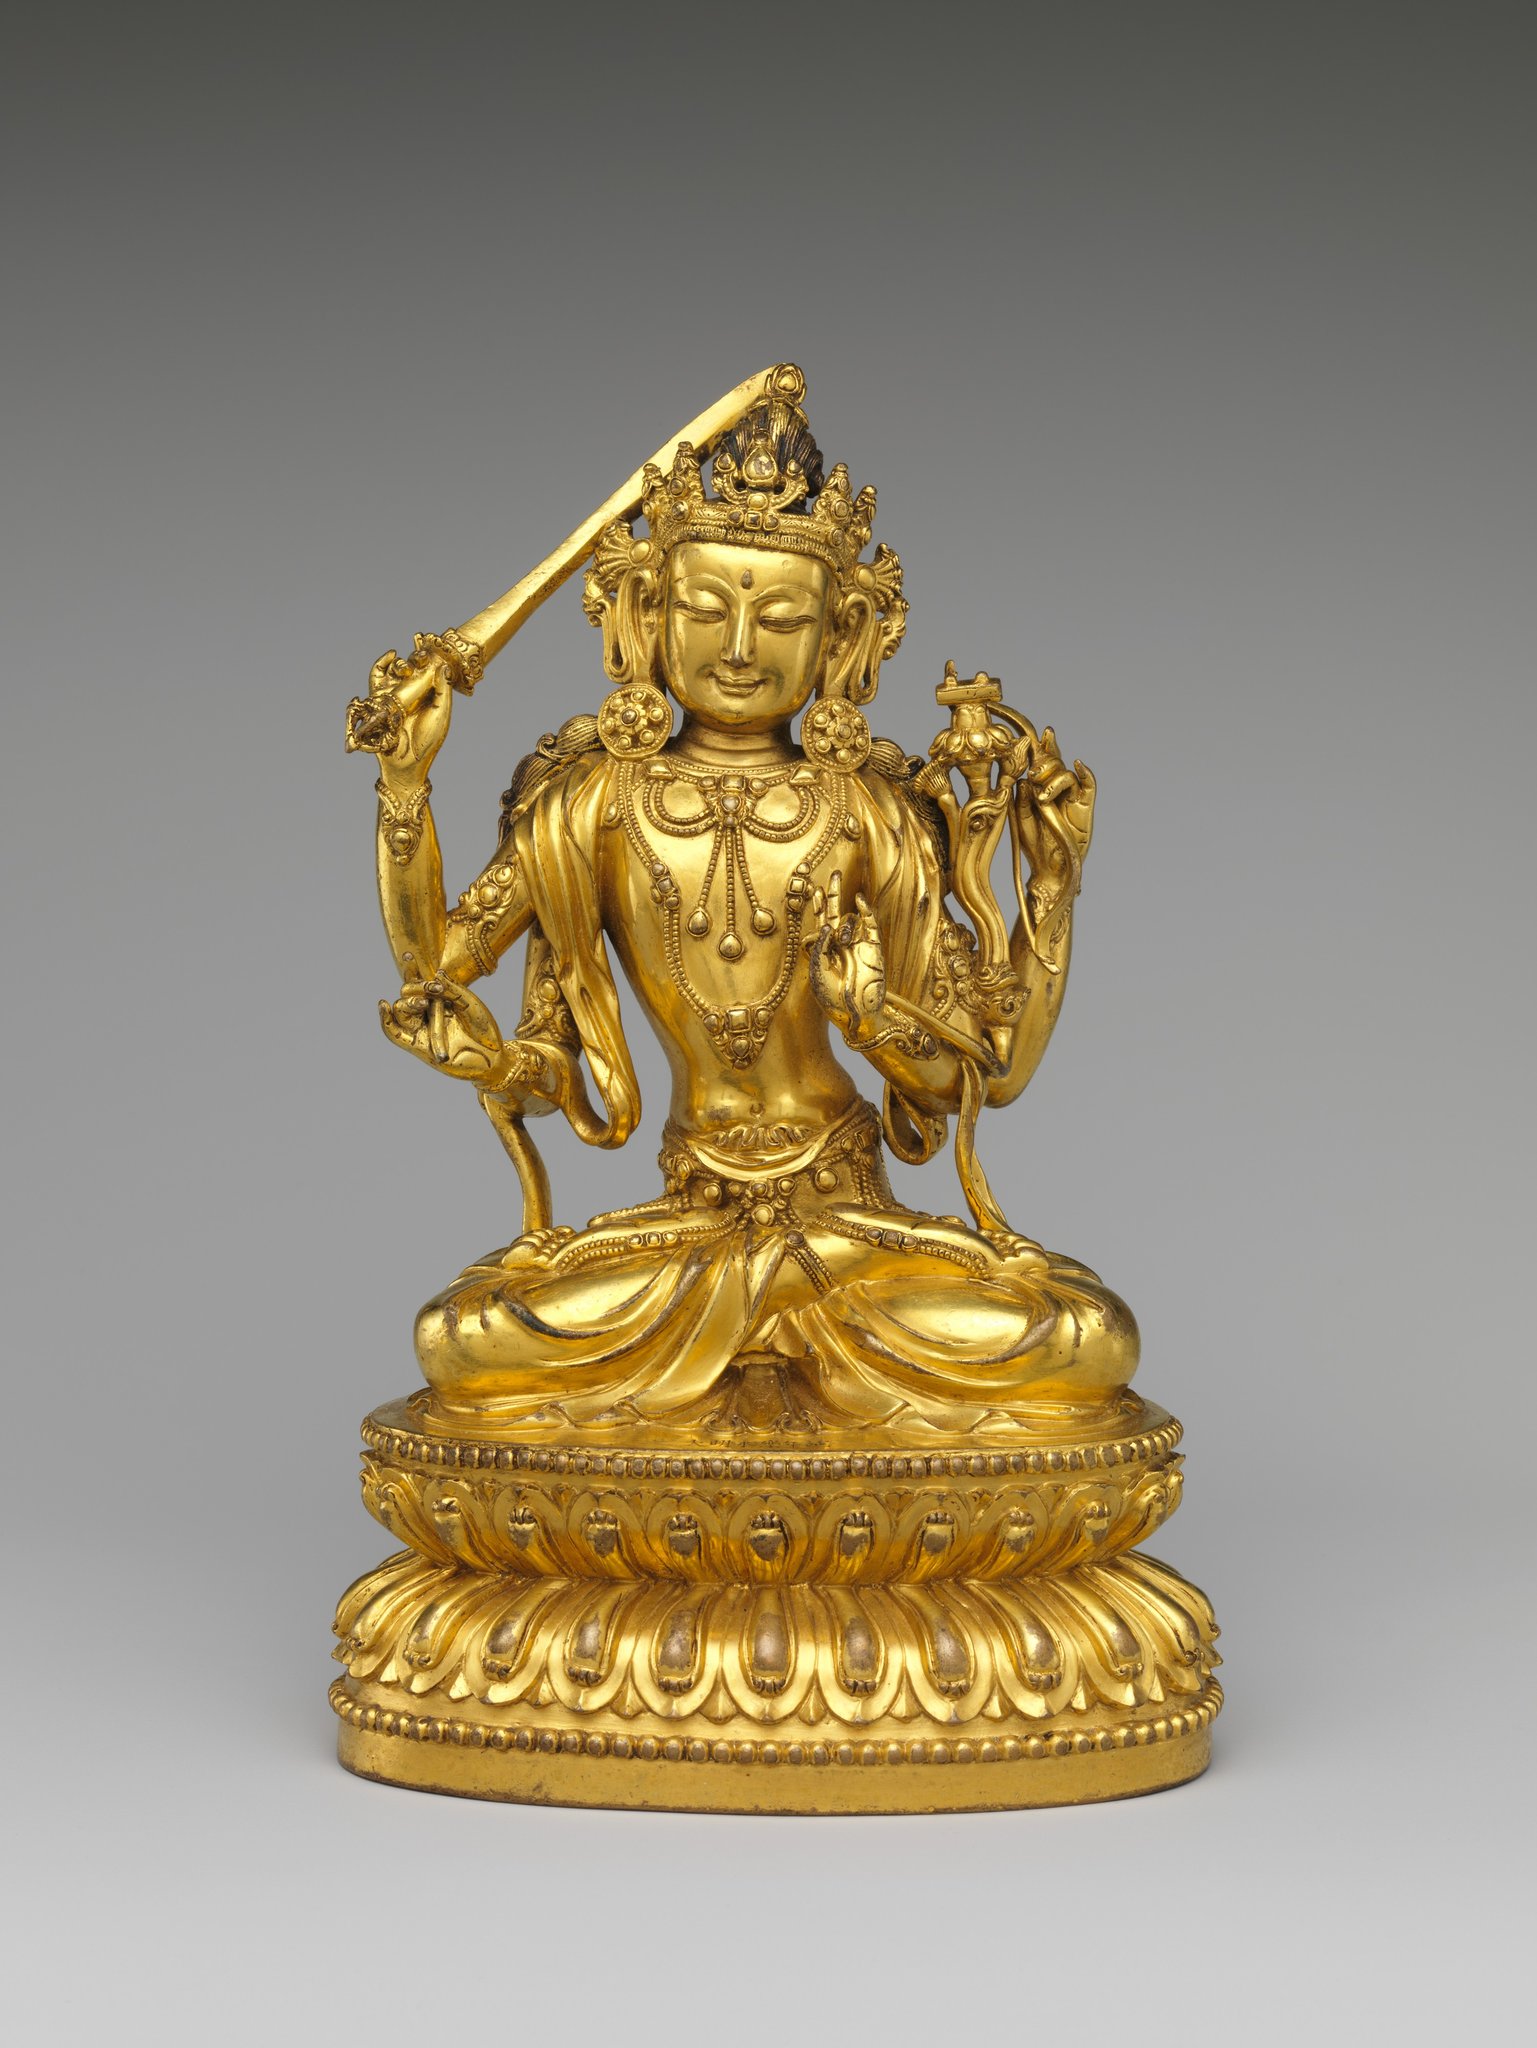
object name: figure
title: Bodhisattva Manjushri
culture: chinese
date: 1403-1424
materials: copper alloy, gilt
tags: swords,buddhism,bodhisattvas,manjushri